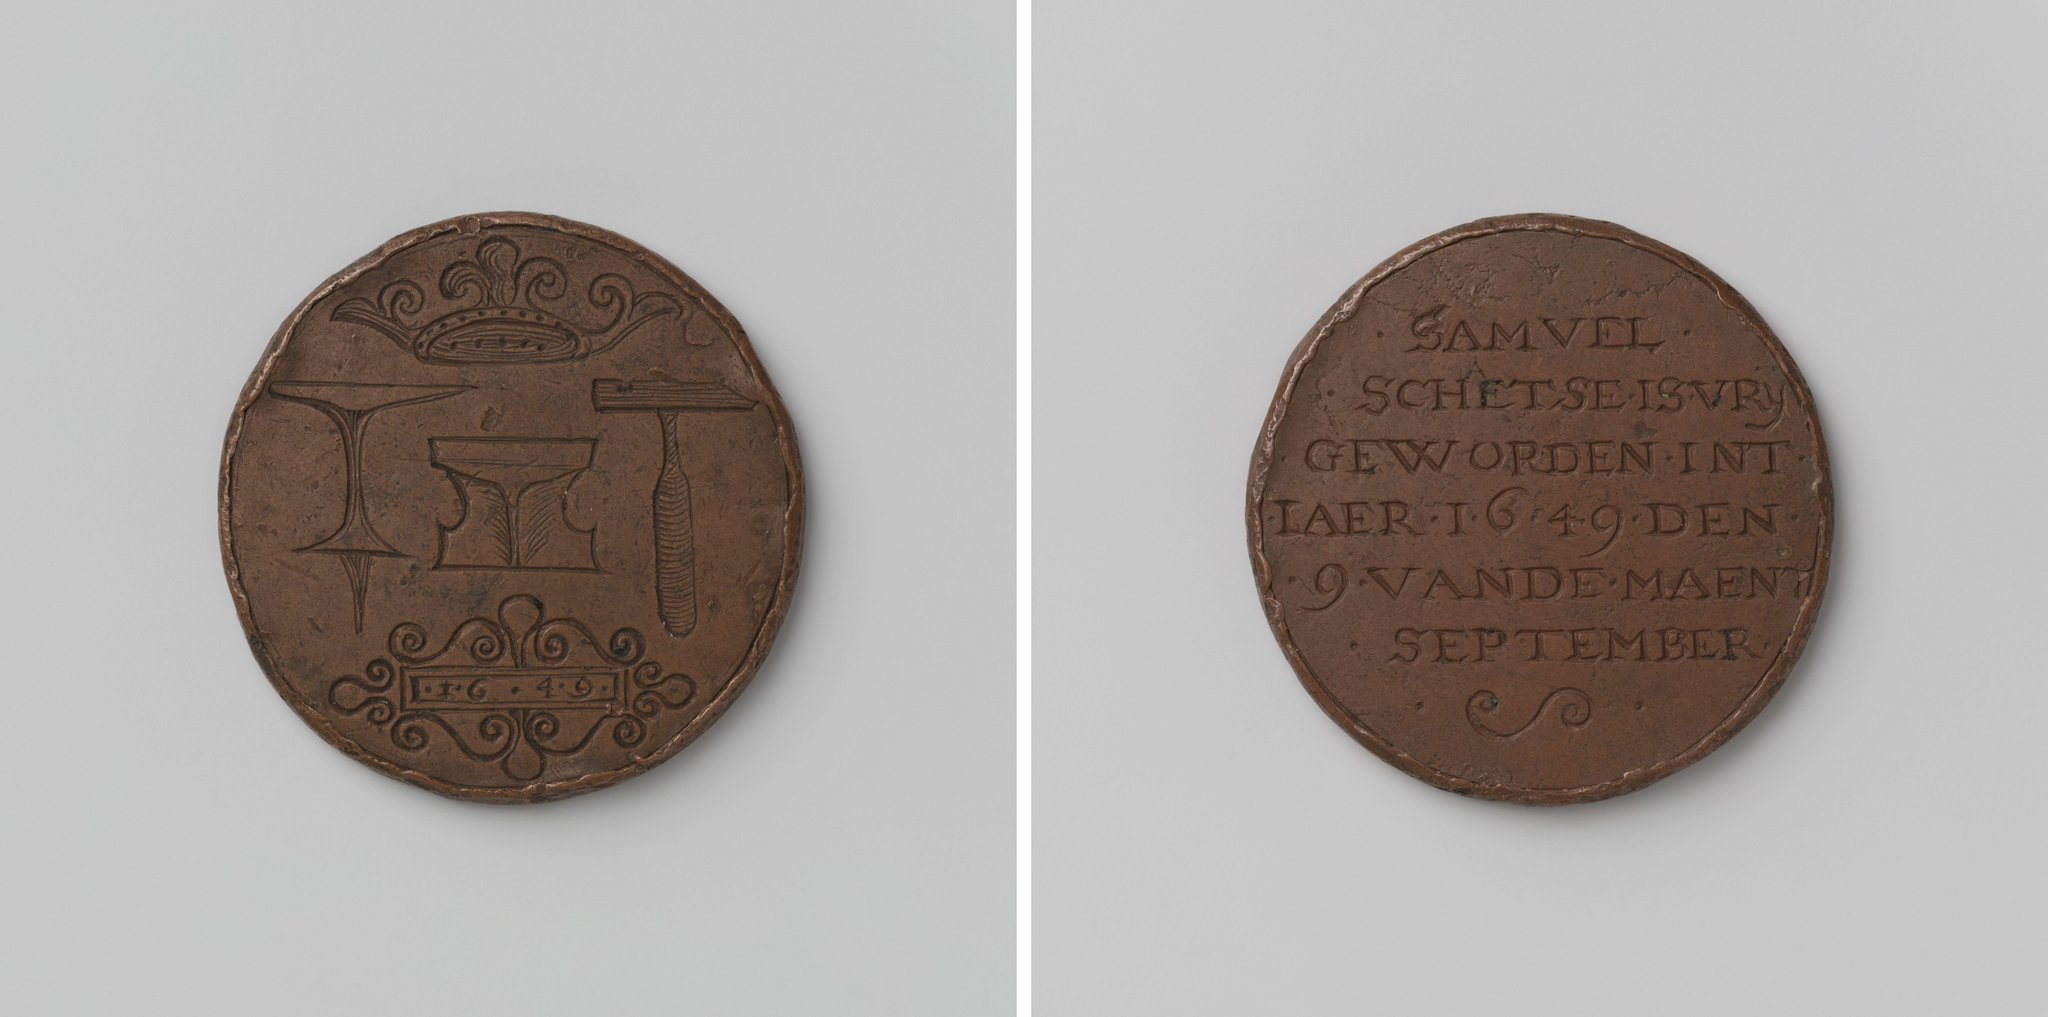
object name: medal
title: Gildepenning van het Smedengilde van een onbekende plaats, op naam van vrij meester Samuel Schetse.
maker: Anonymous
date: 1649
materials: copper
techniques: engraving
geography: netherlands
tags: samuel schetse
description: Koperen penning. Voorzijde: gekroond aambeeld tussen puntig aambeeld en voorslaghamer boven versierd compartiment met jaartal. Keerzijde: opschrift